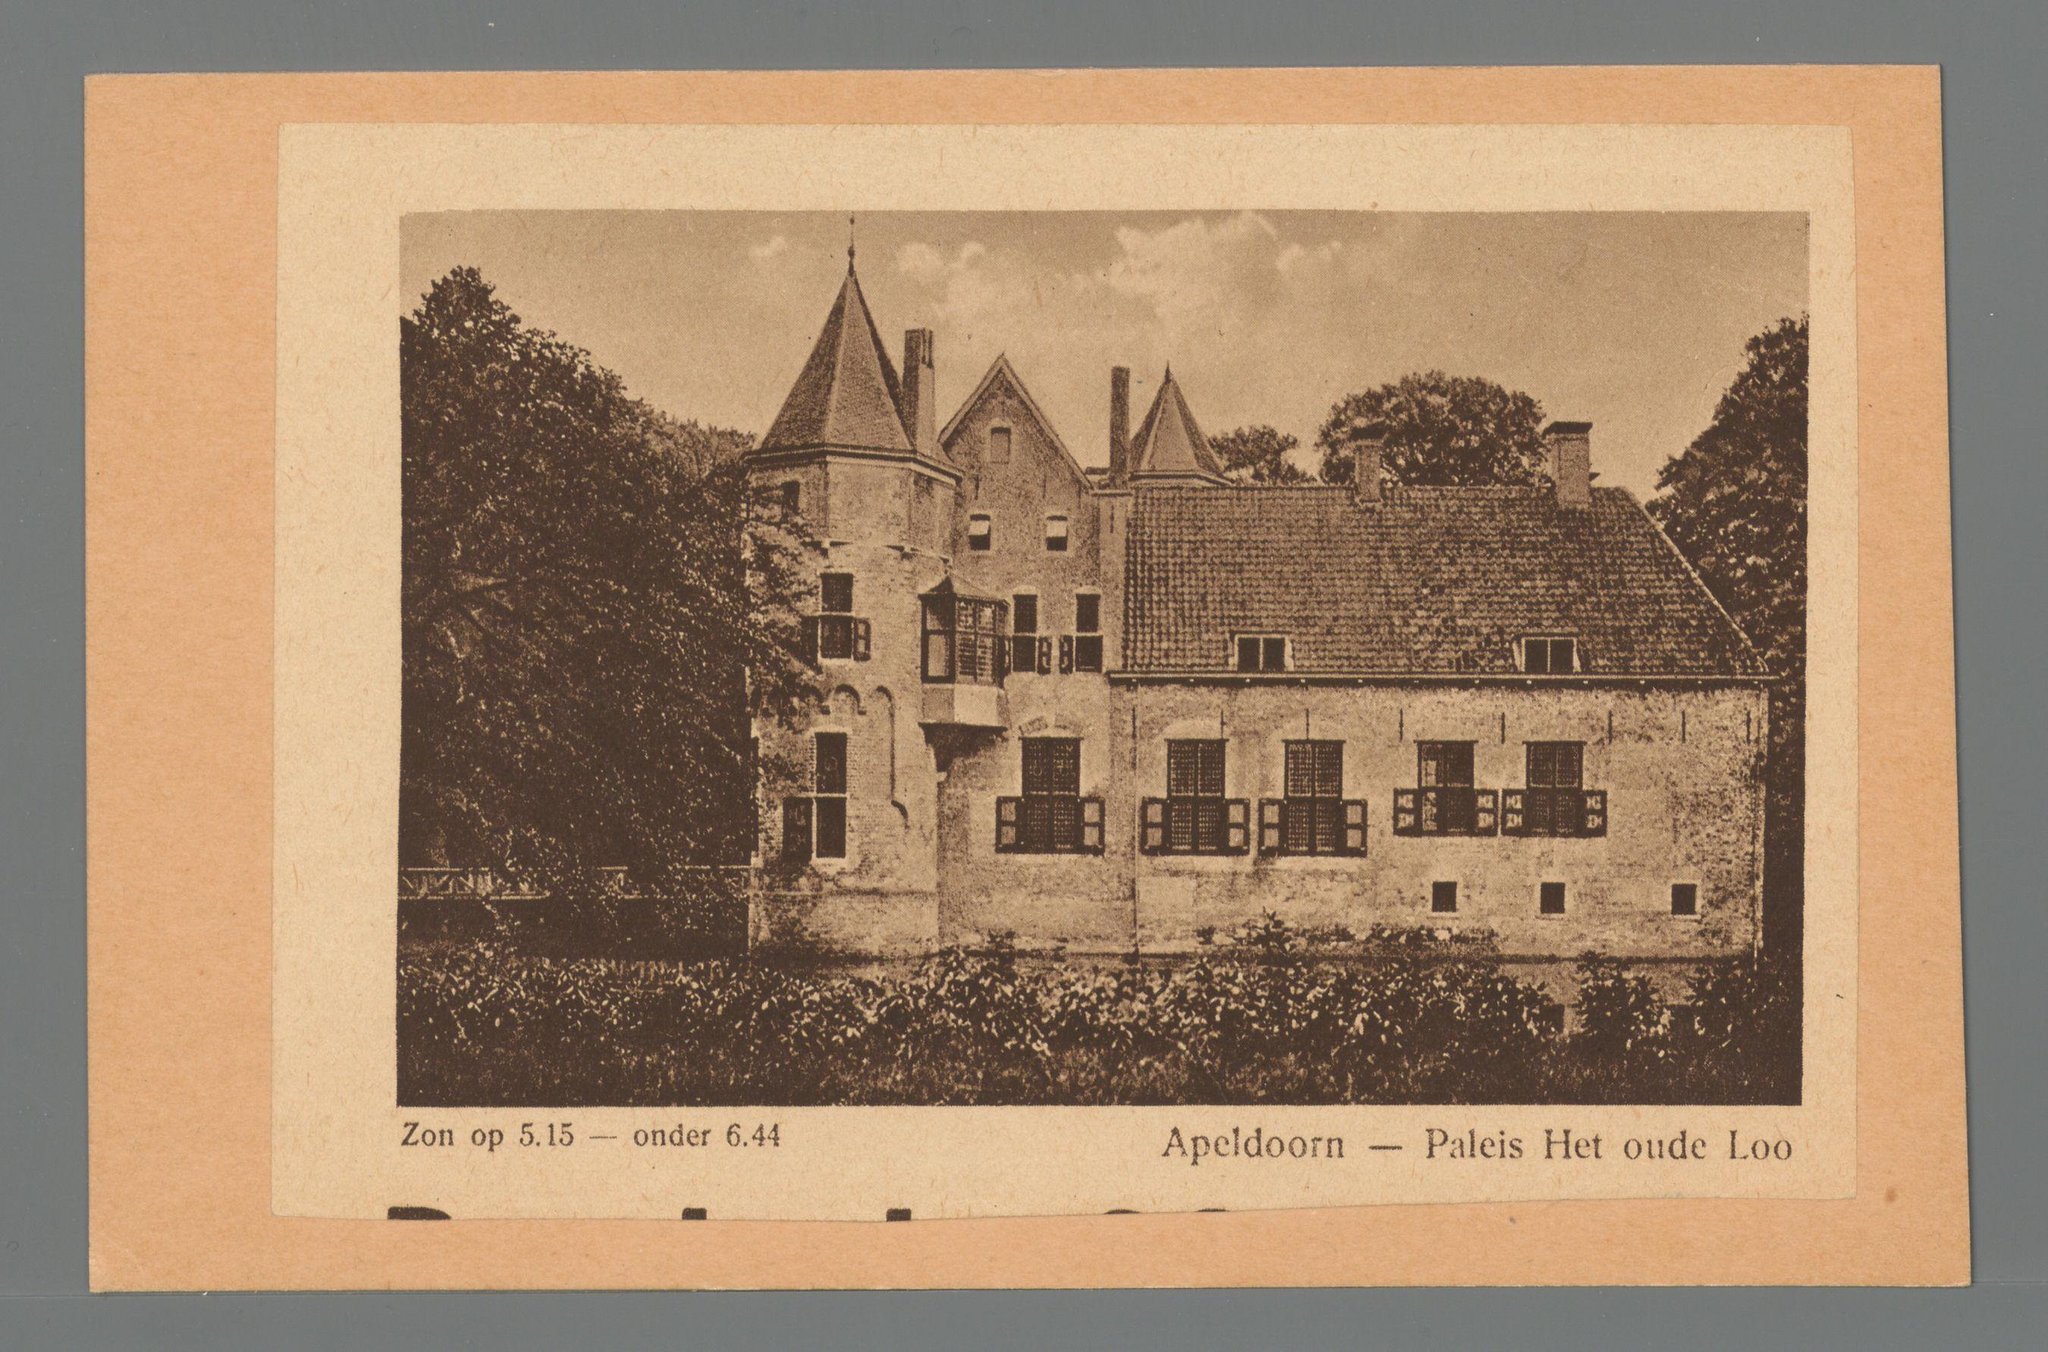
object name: photomechanical print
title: Apeldoorn - Paleis Het oude Loo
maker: Anonymous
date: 1895-1930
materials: cardboard, paper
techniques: rotogravure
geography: apeldoorn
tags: castle